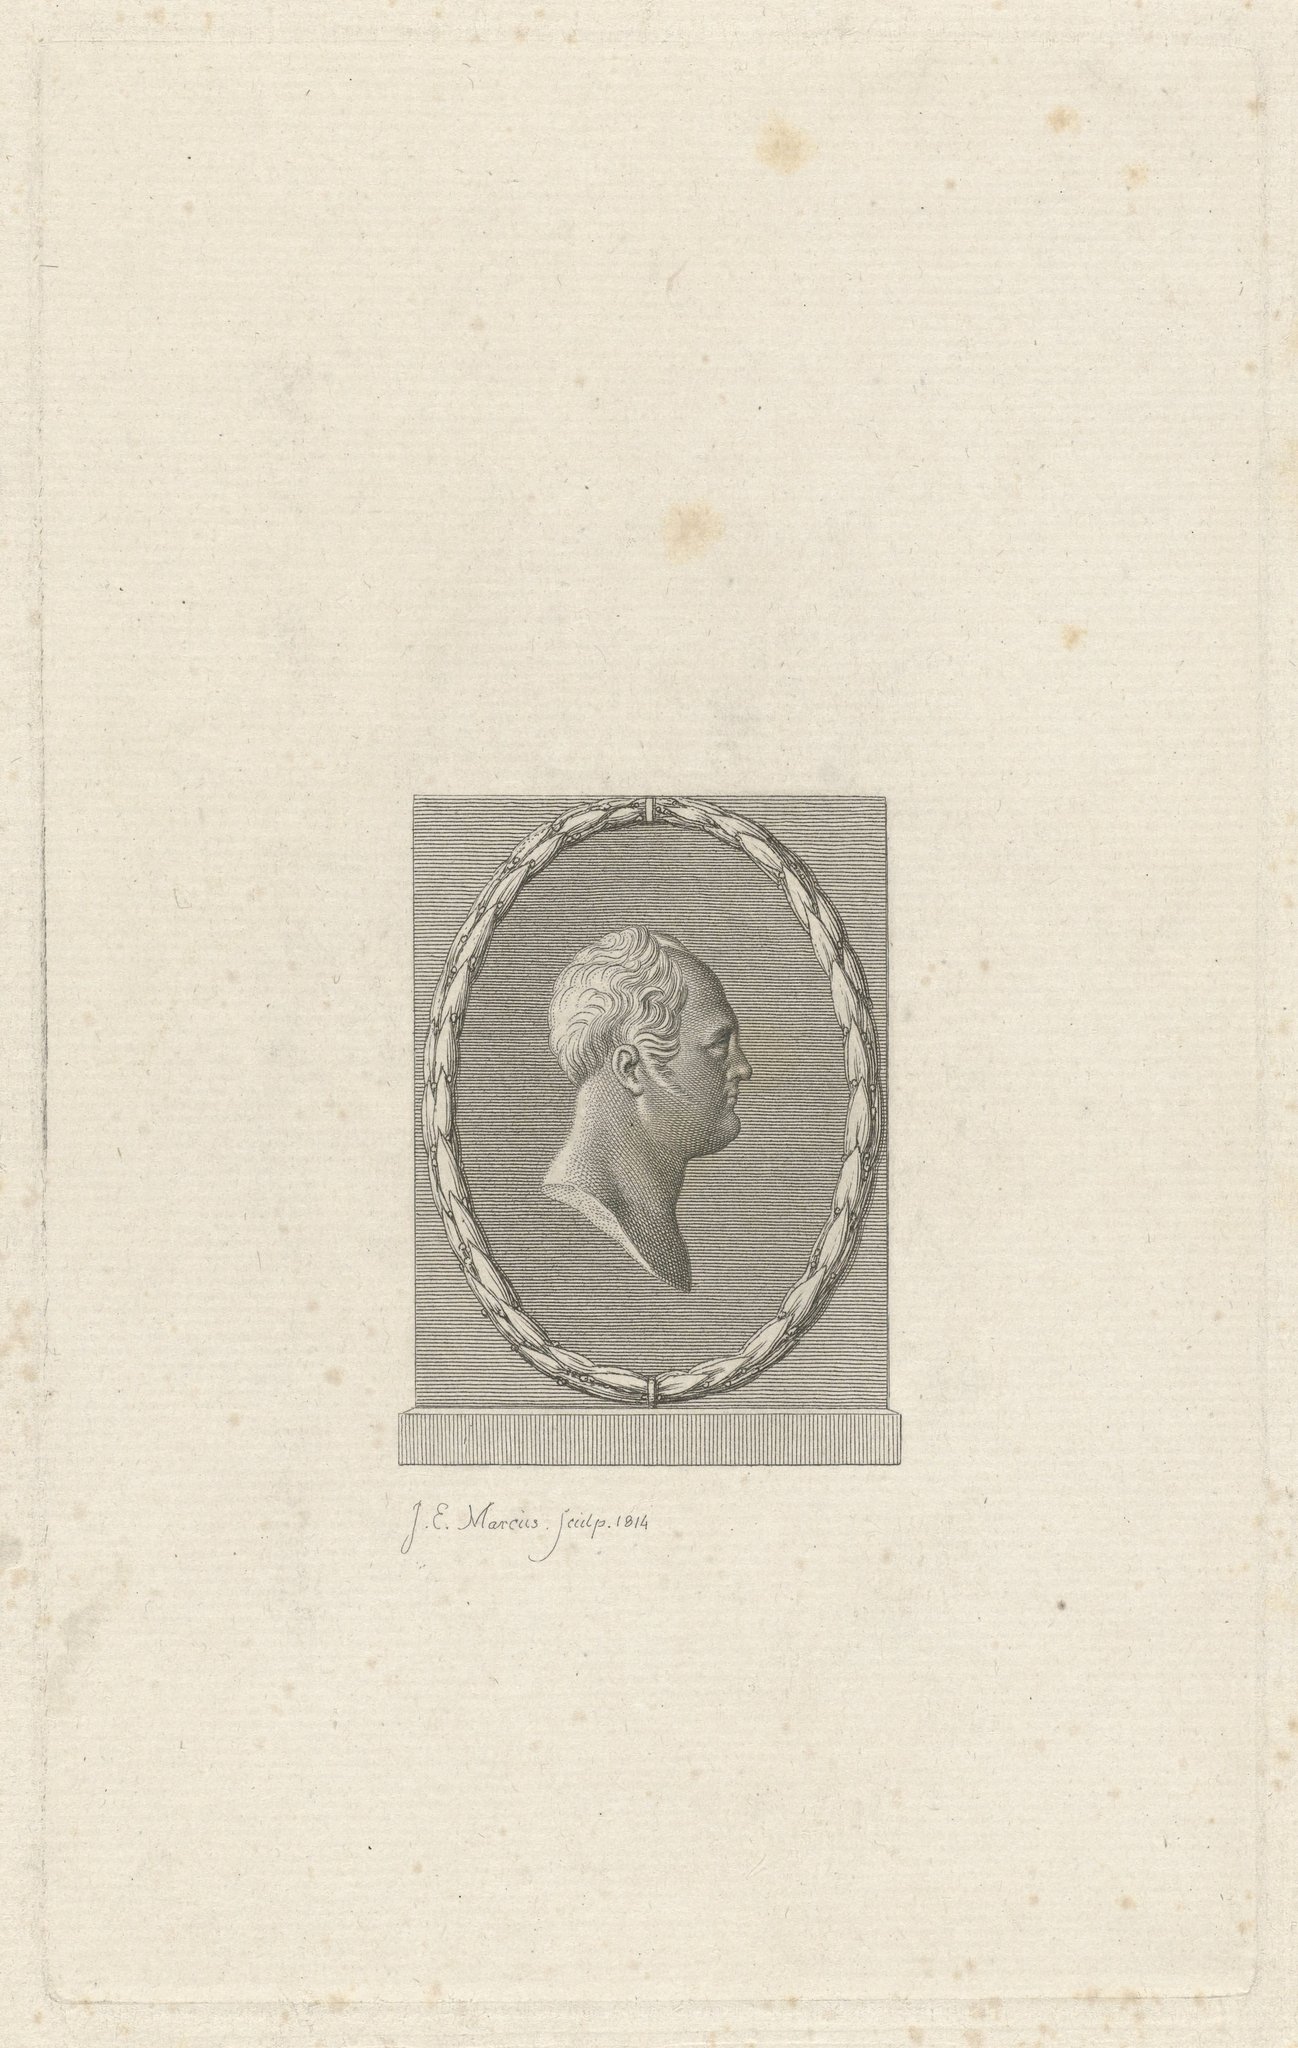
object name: print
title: Portret van Alexander I, tsaar van Rusland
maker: jacob ernst marcus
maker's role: draughtsman, print maker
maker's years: 1774-1826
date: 1814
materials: paper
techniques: engraving, etching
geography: amsterdam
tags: alexander i (tsaar van rusland)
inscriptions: collector's mark: Lugt 2228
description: Bosrtbeeld van Alexander I, tsaar van Rusland naar rechts, in een ovale lauwerkrans.